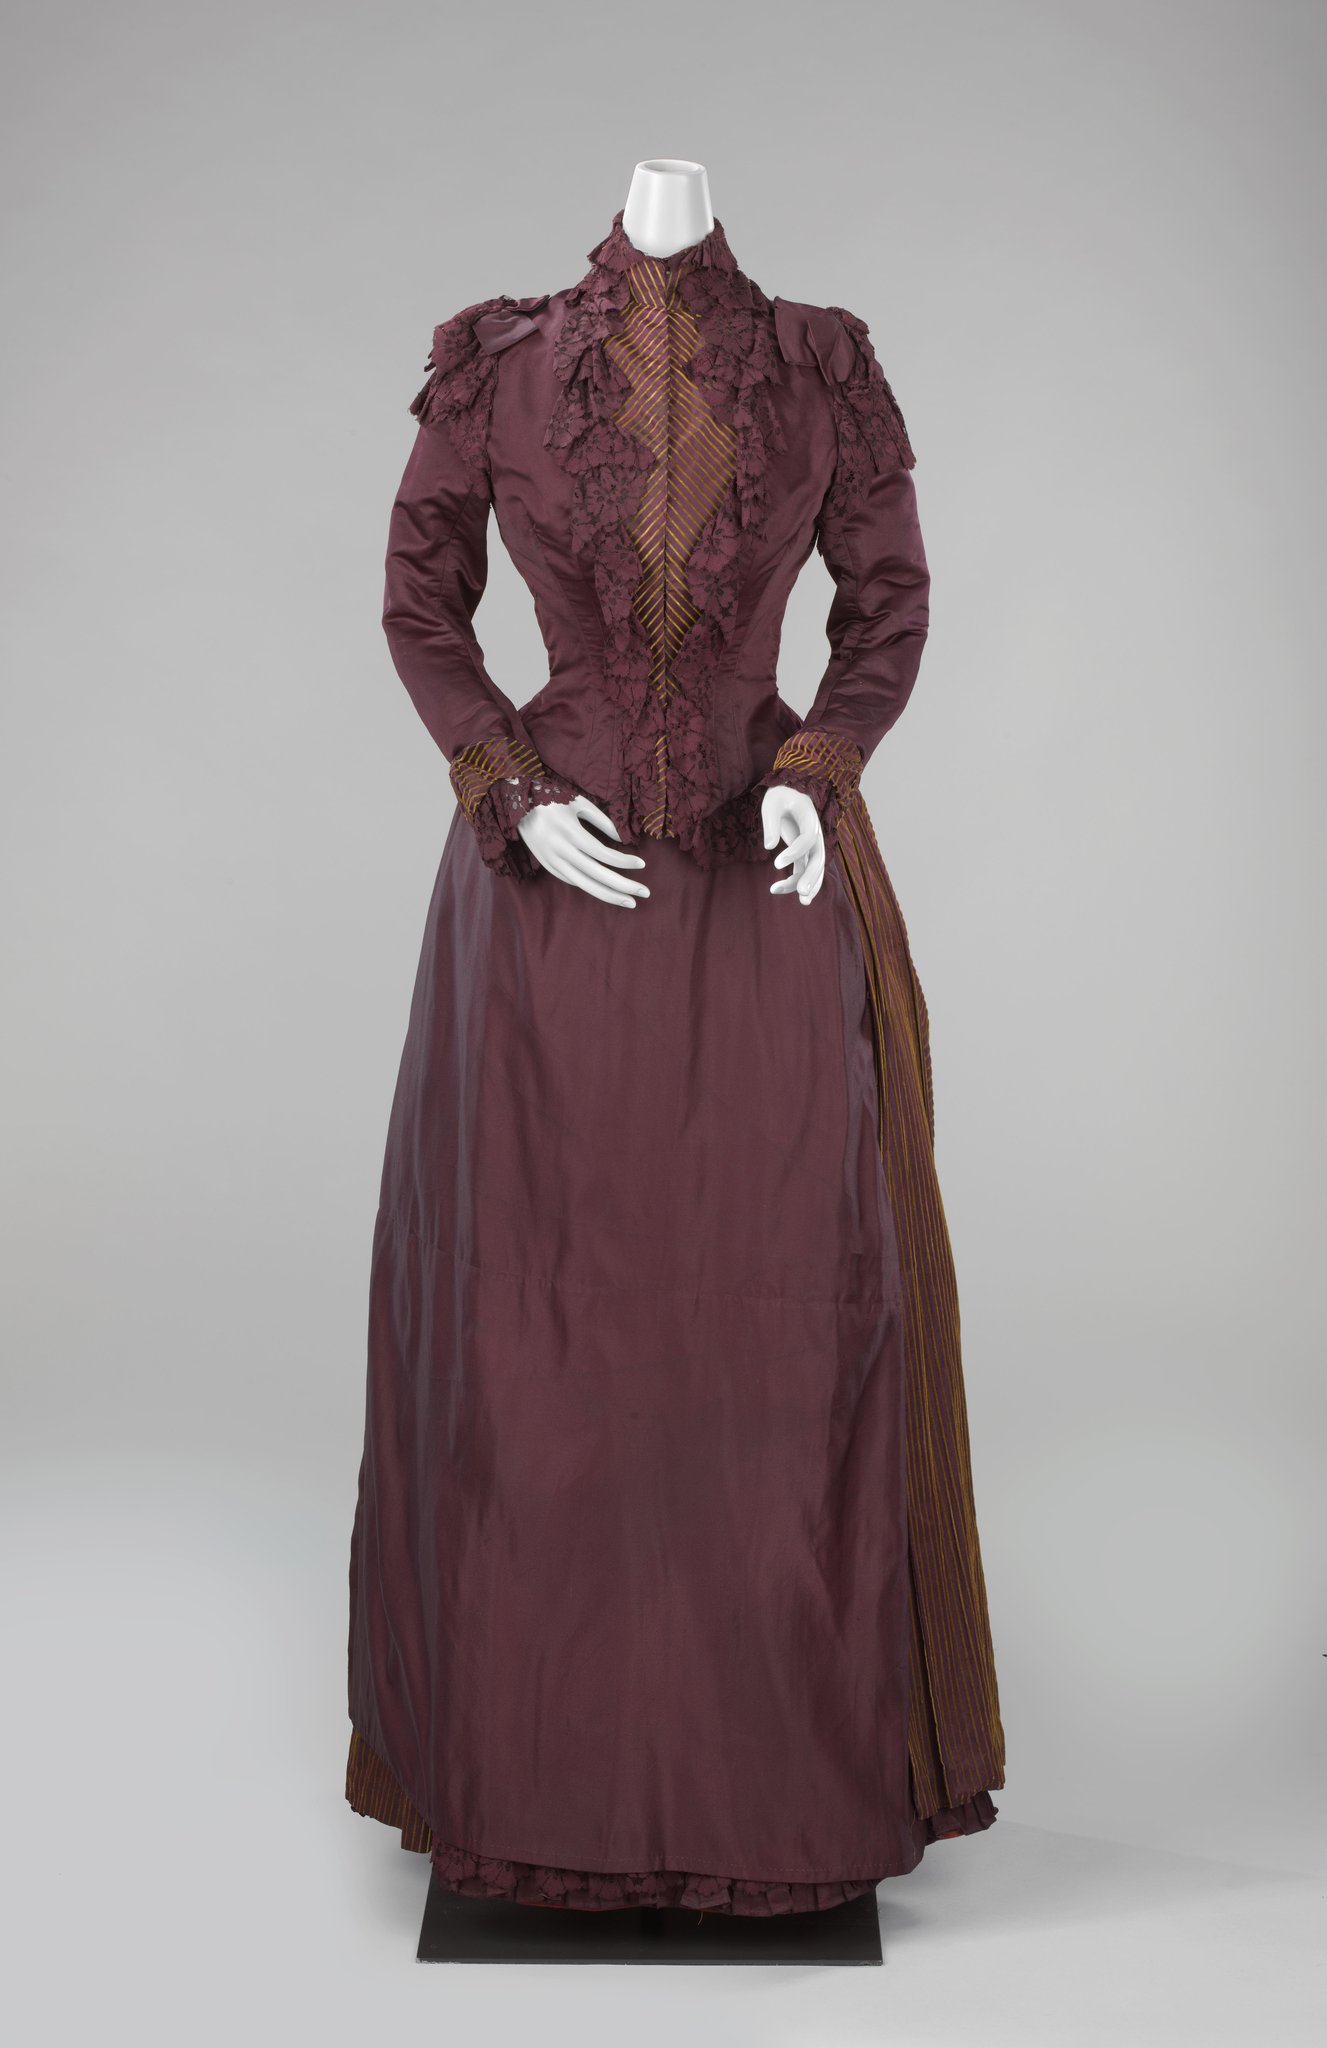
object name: main garment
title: Lijf met lange mouw en hoge boord van bordeauxkleurig satijn versierd met gele fluwelen strepen, bordeauxkleurige satijnen strikken en bordeauxkleurige kanten ruches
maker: Anonymous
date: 1875-1900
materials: textile, velvet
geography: netherlands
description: Lijf met lange mouw en hoge boord van bordeauxkleurig satijn versierd met gele fluwelen strepen, bordeauxkleurige satijnen strikken en bordeauxkleurige kanten ruches.